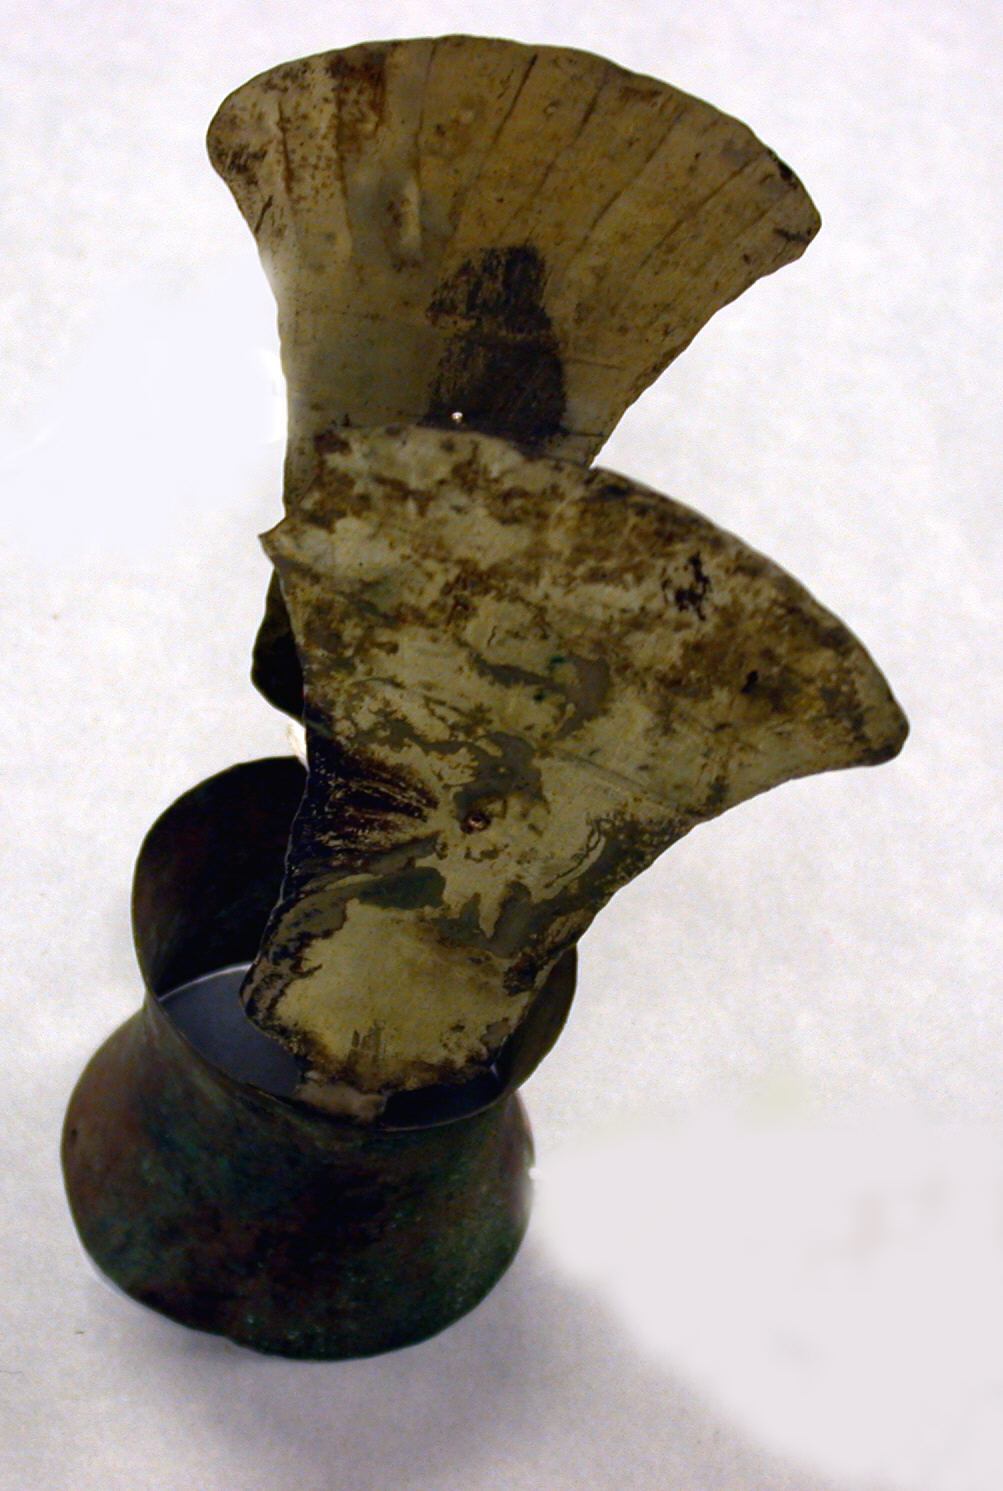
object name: crown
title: Hammered Silver Miniature Crown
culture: peruvian, north or central coast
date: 1001-1566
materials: gilt, silver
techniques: hammering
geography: peru